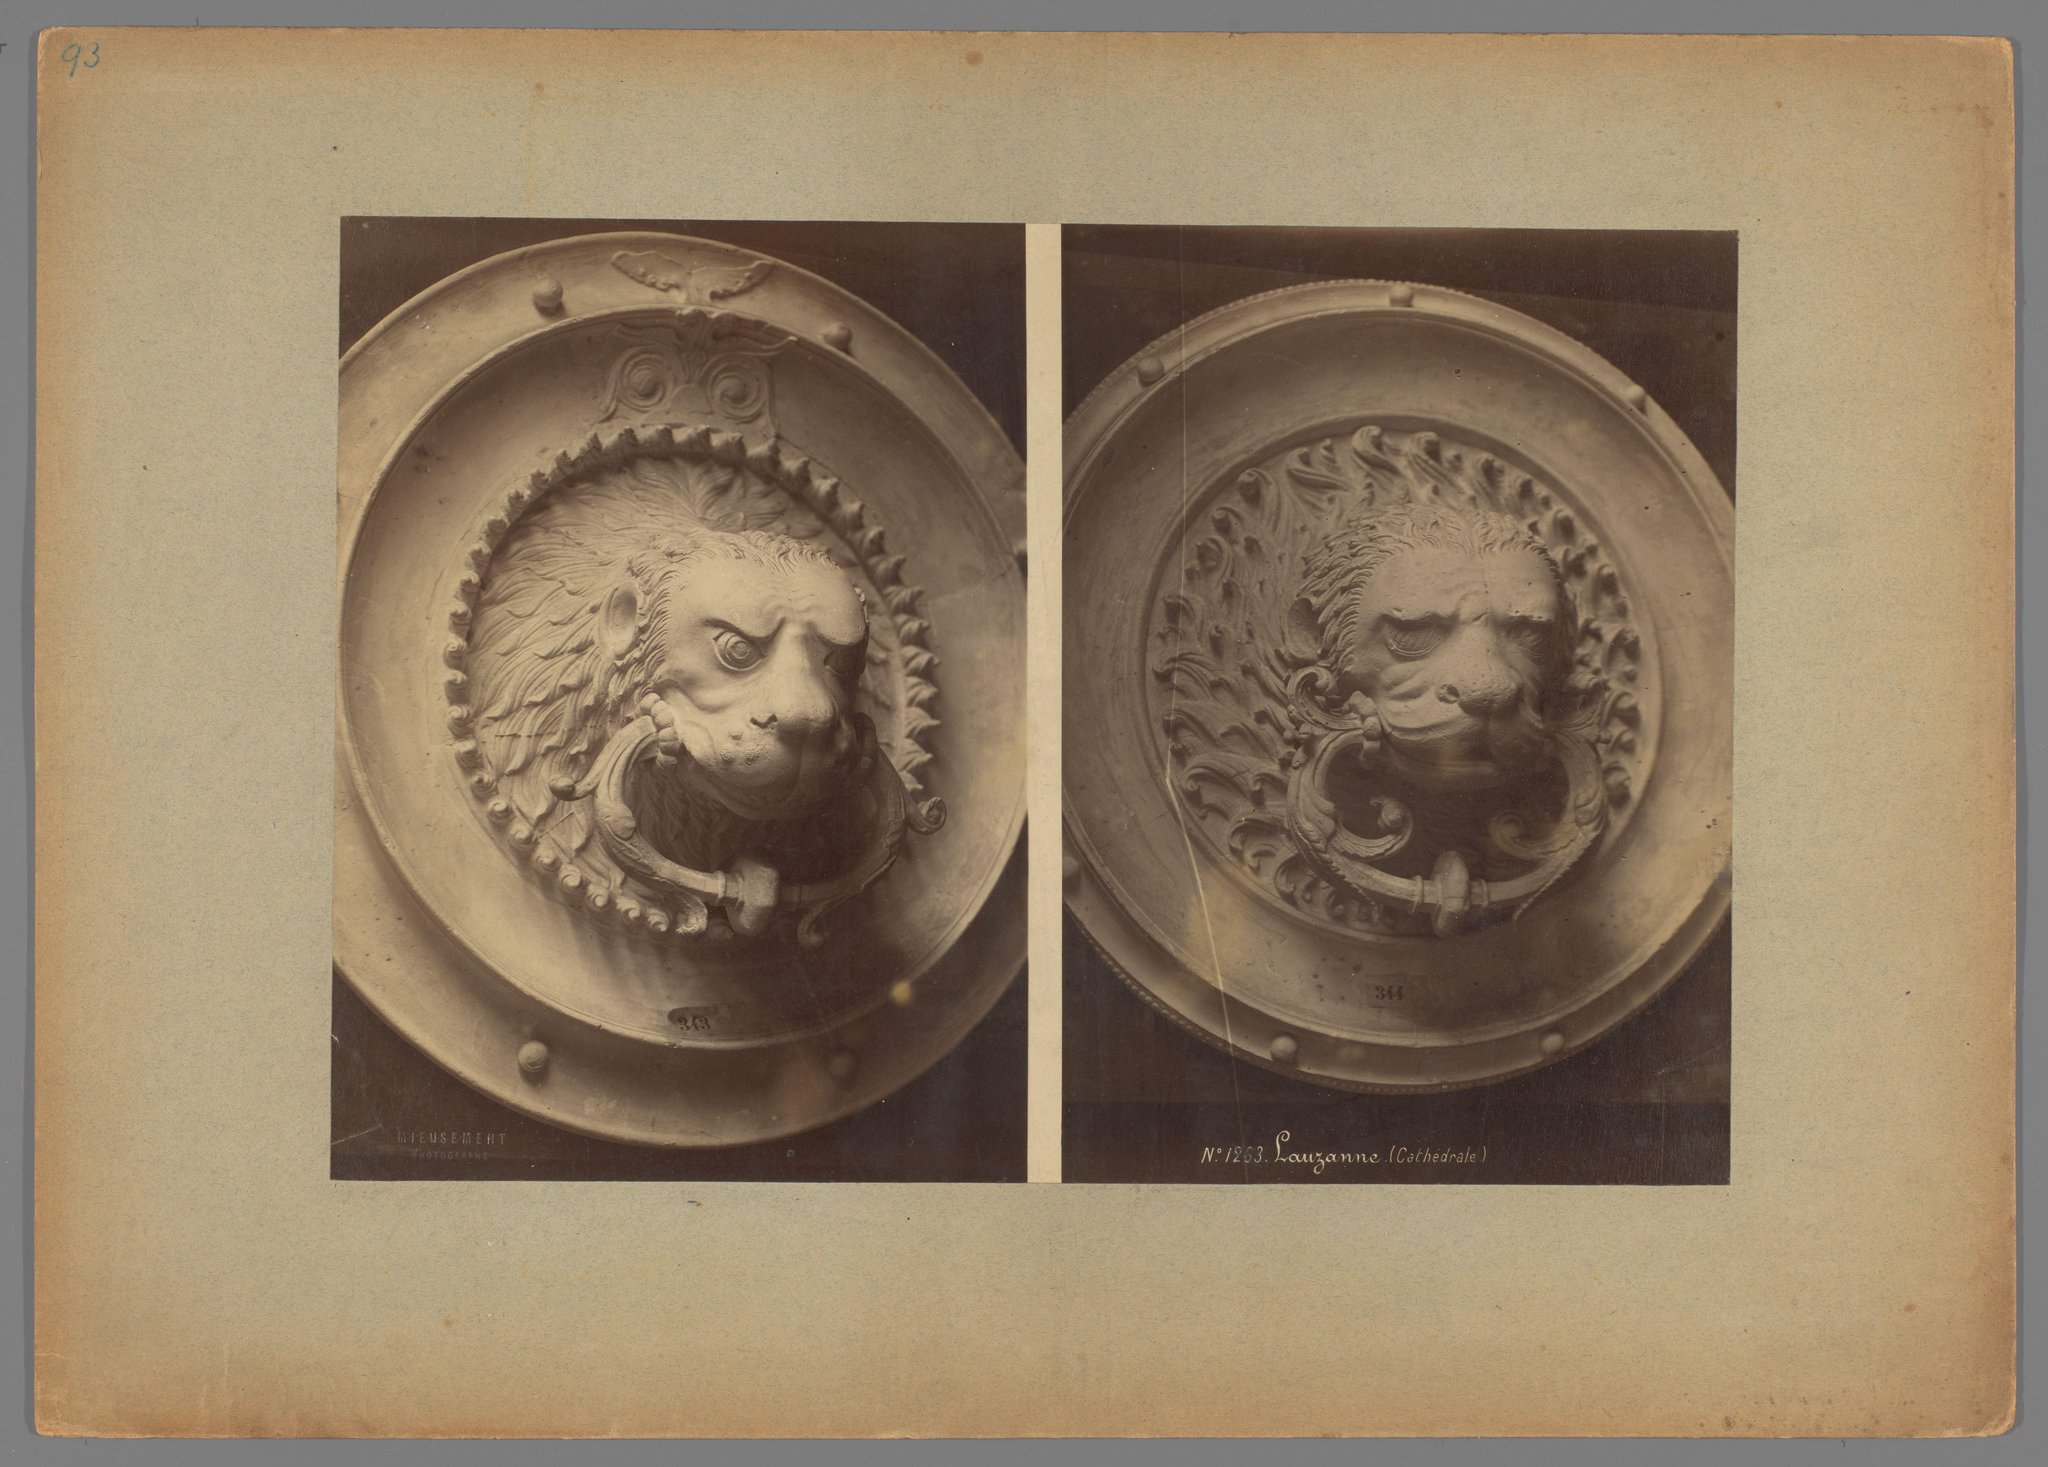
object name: photograph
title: Twee deurkloppers als in de Kathedraal van Lausanne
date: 1850-1900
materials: cardboard, photographic support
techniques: albumen print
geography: autun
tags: lion's head ~ ornament, door-knocker, doorbell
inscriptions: inscription: ‘(Cathédrale)’, check stamp: ‘[...]’, number: ‘No. 1263’, workshop stamp: ‘Kunsthandel/ J.A.G. de Leur/ Photograaf- Uitgever/ Huigenspark, 40b,/ Den Haag’, collector's mark: ‘Rijks-normaalschool voor teekenonderwijzers [Amsterdam]’